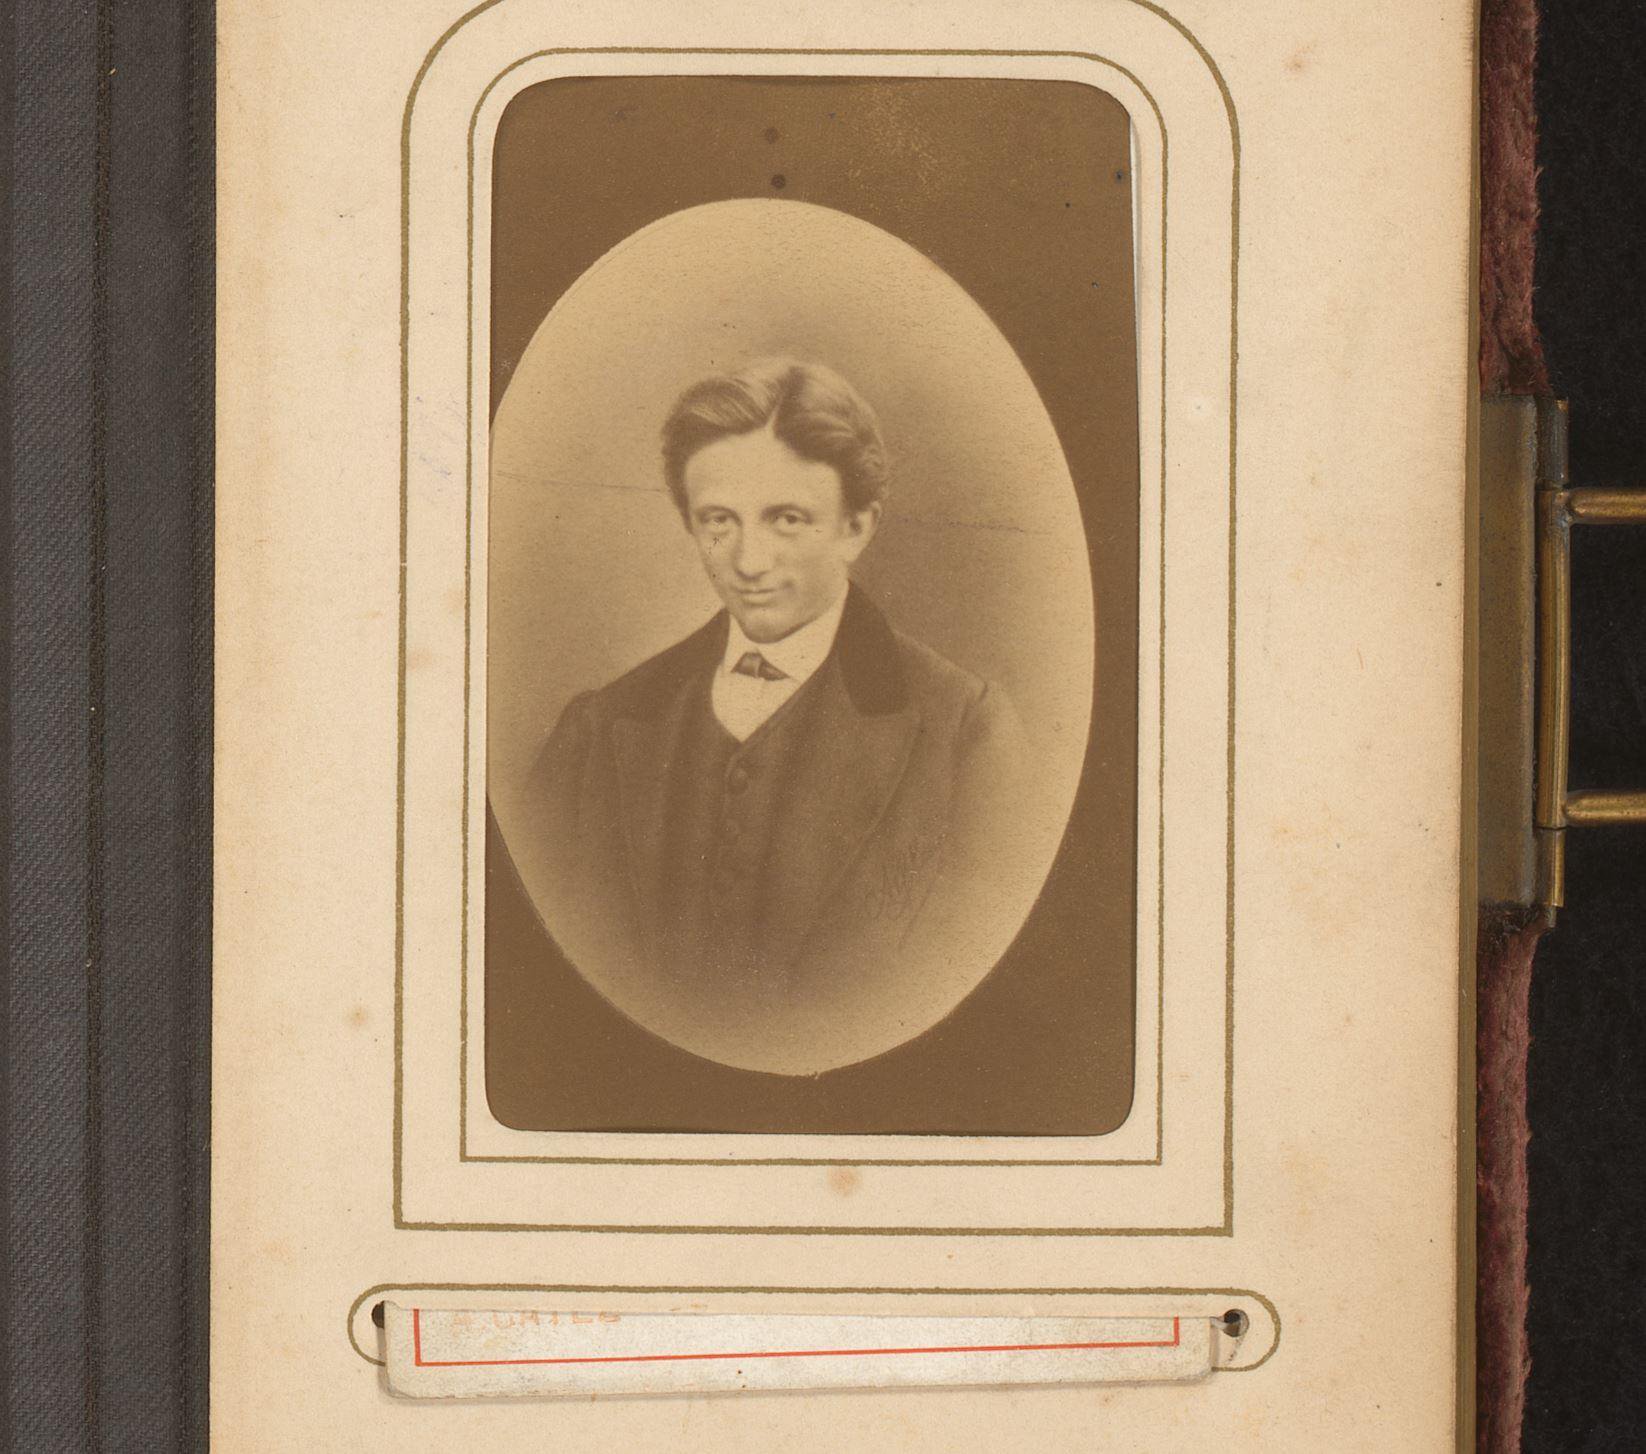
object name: album leaf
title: Portret van een man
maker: albert cayez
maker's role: fotograaf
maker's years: 1845-1916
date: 1860-1900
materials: cardboard, photographic support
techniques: albumen print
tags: adult man, historical persons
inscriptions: inscription: ‘A. Cayez’, annotation: ‘Alexandre [...]/ le marí de [...]/ Gabrielle, père/ de/ Lionel/ Desdemone (...)/ Régine/ Francis (...)/ de [...]/ Marianne’